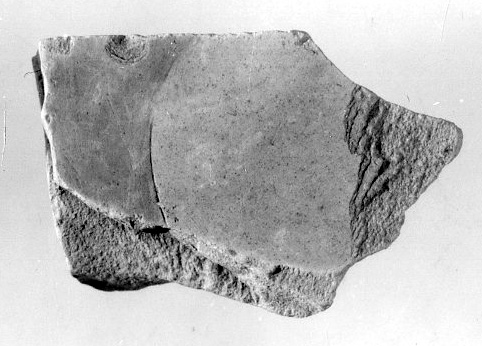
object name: relief fragment, tomb of meketre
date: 1981-1975 BCE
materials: limestone, paint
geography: egypt